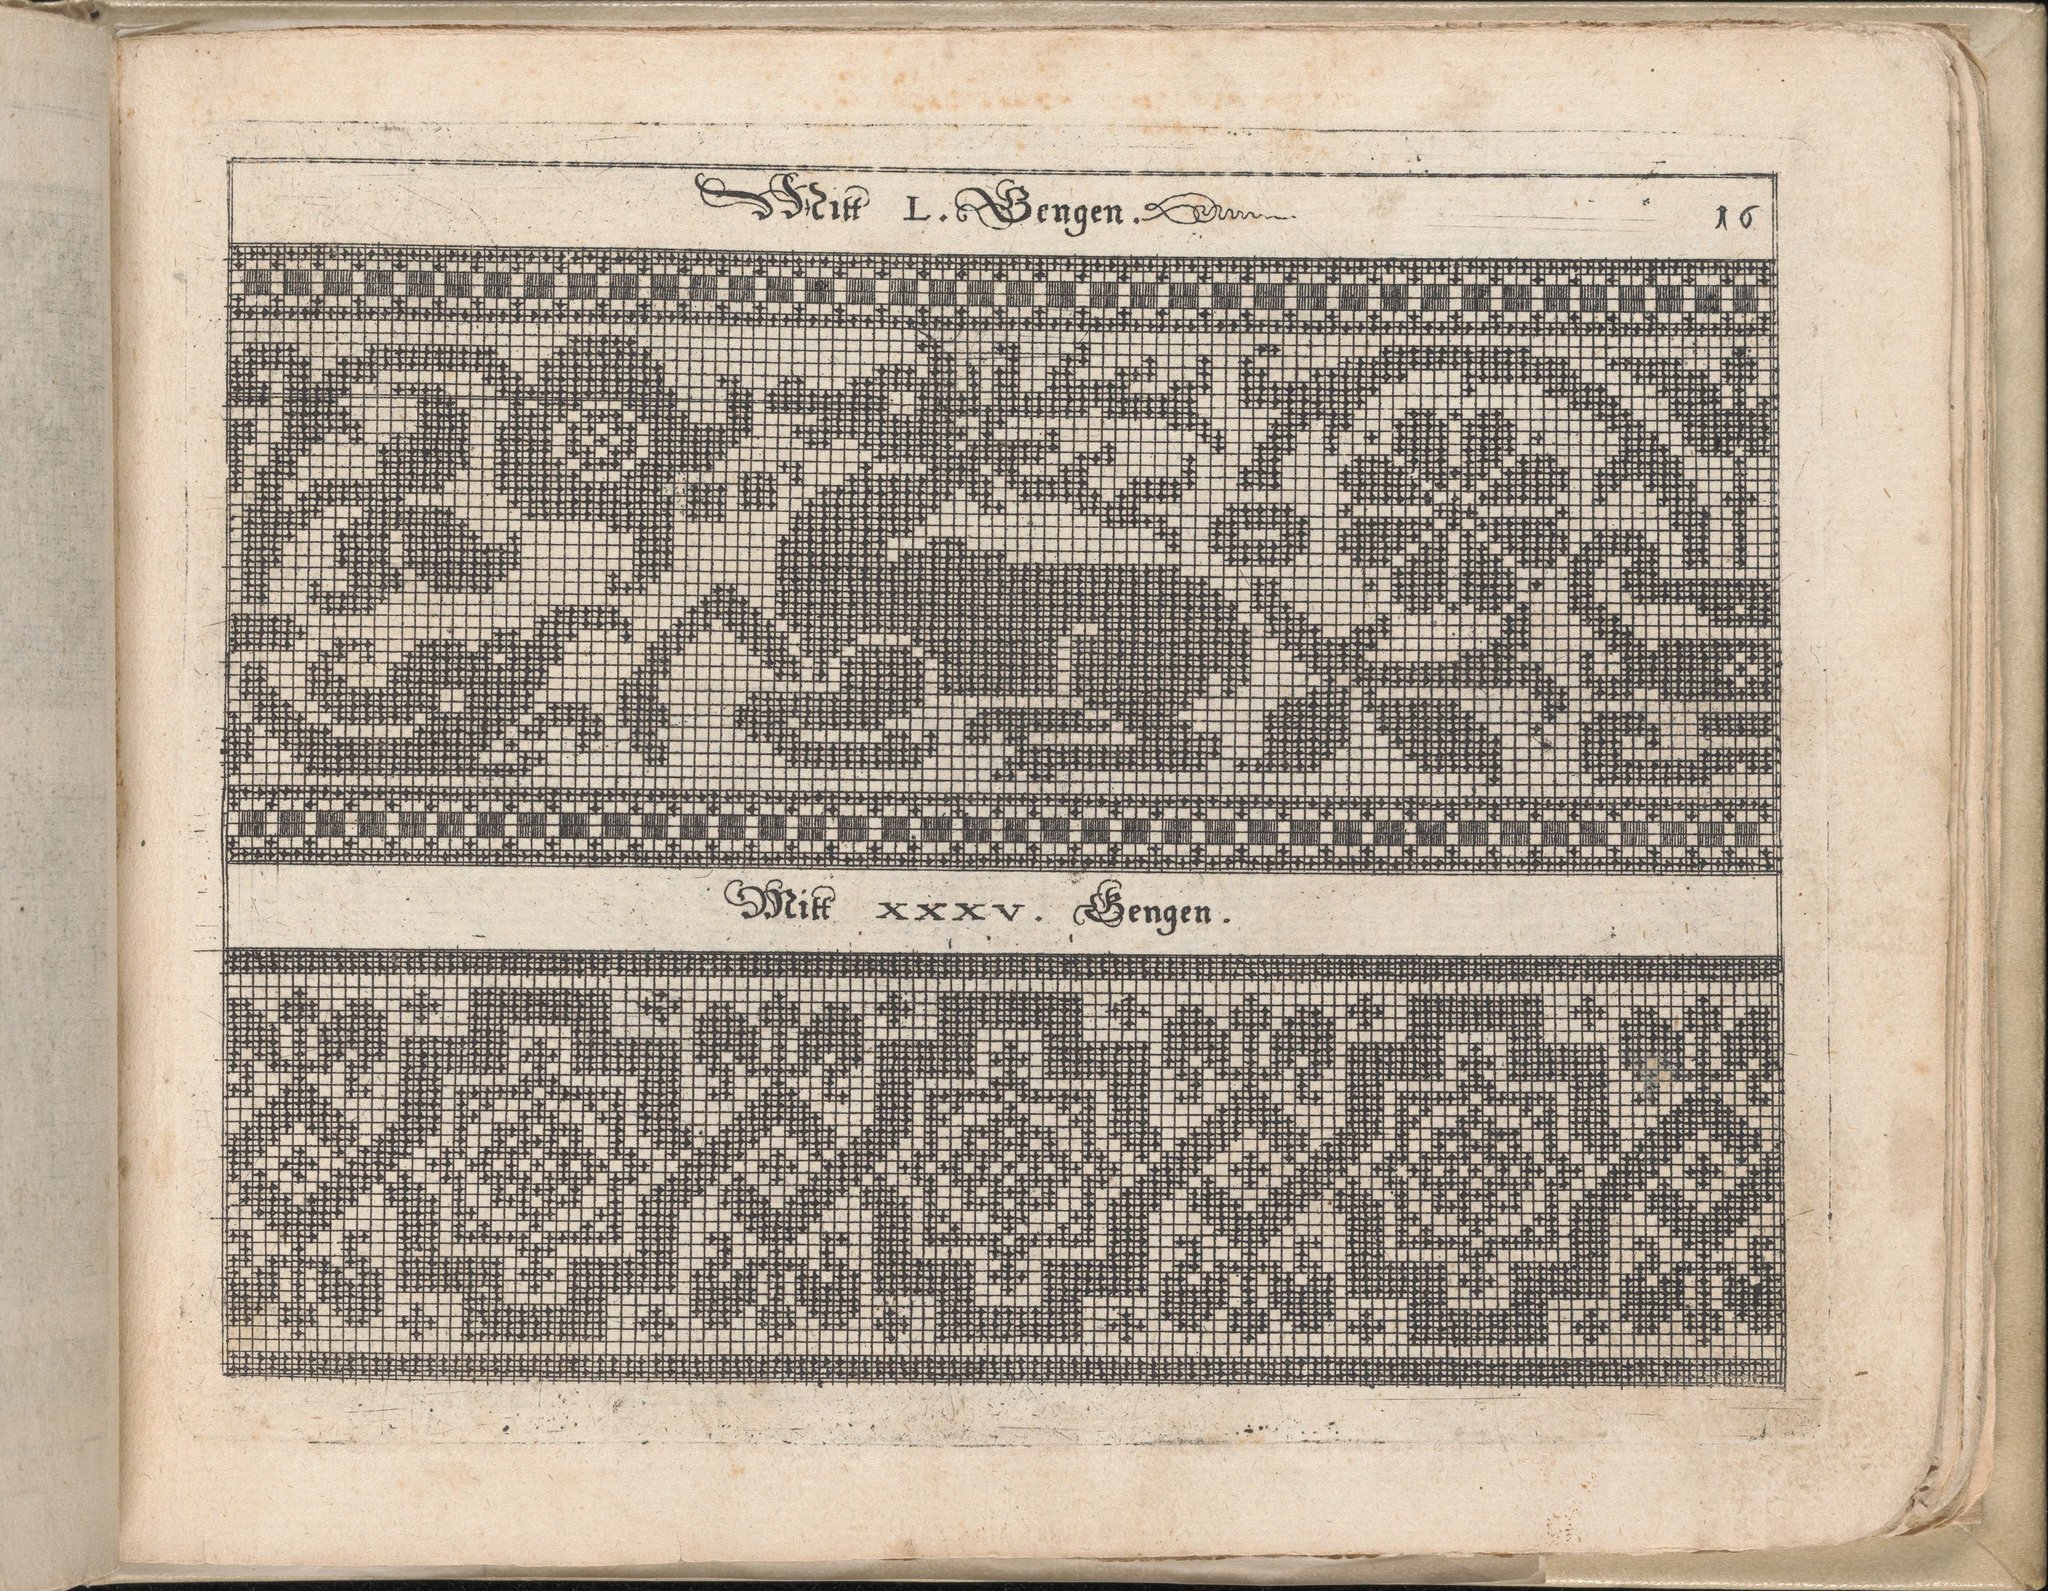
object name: book print ornament architecture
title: Schön Neues Modelbuch (Page 21 recto)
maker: johann sibmacher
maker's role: designer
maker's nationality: german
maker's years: 1590-1611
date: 1597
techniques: etching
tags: deer,flowers